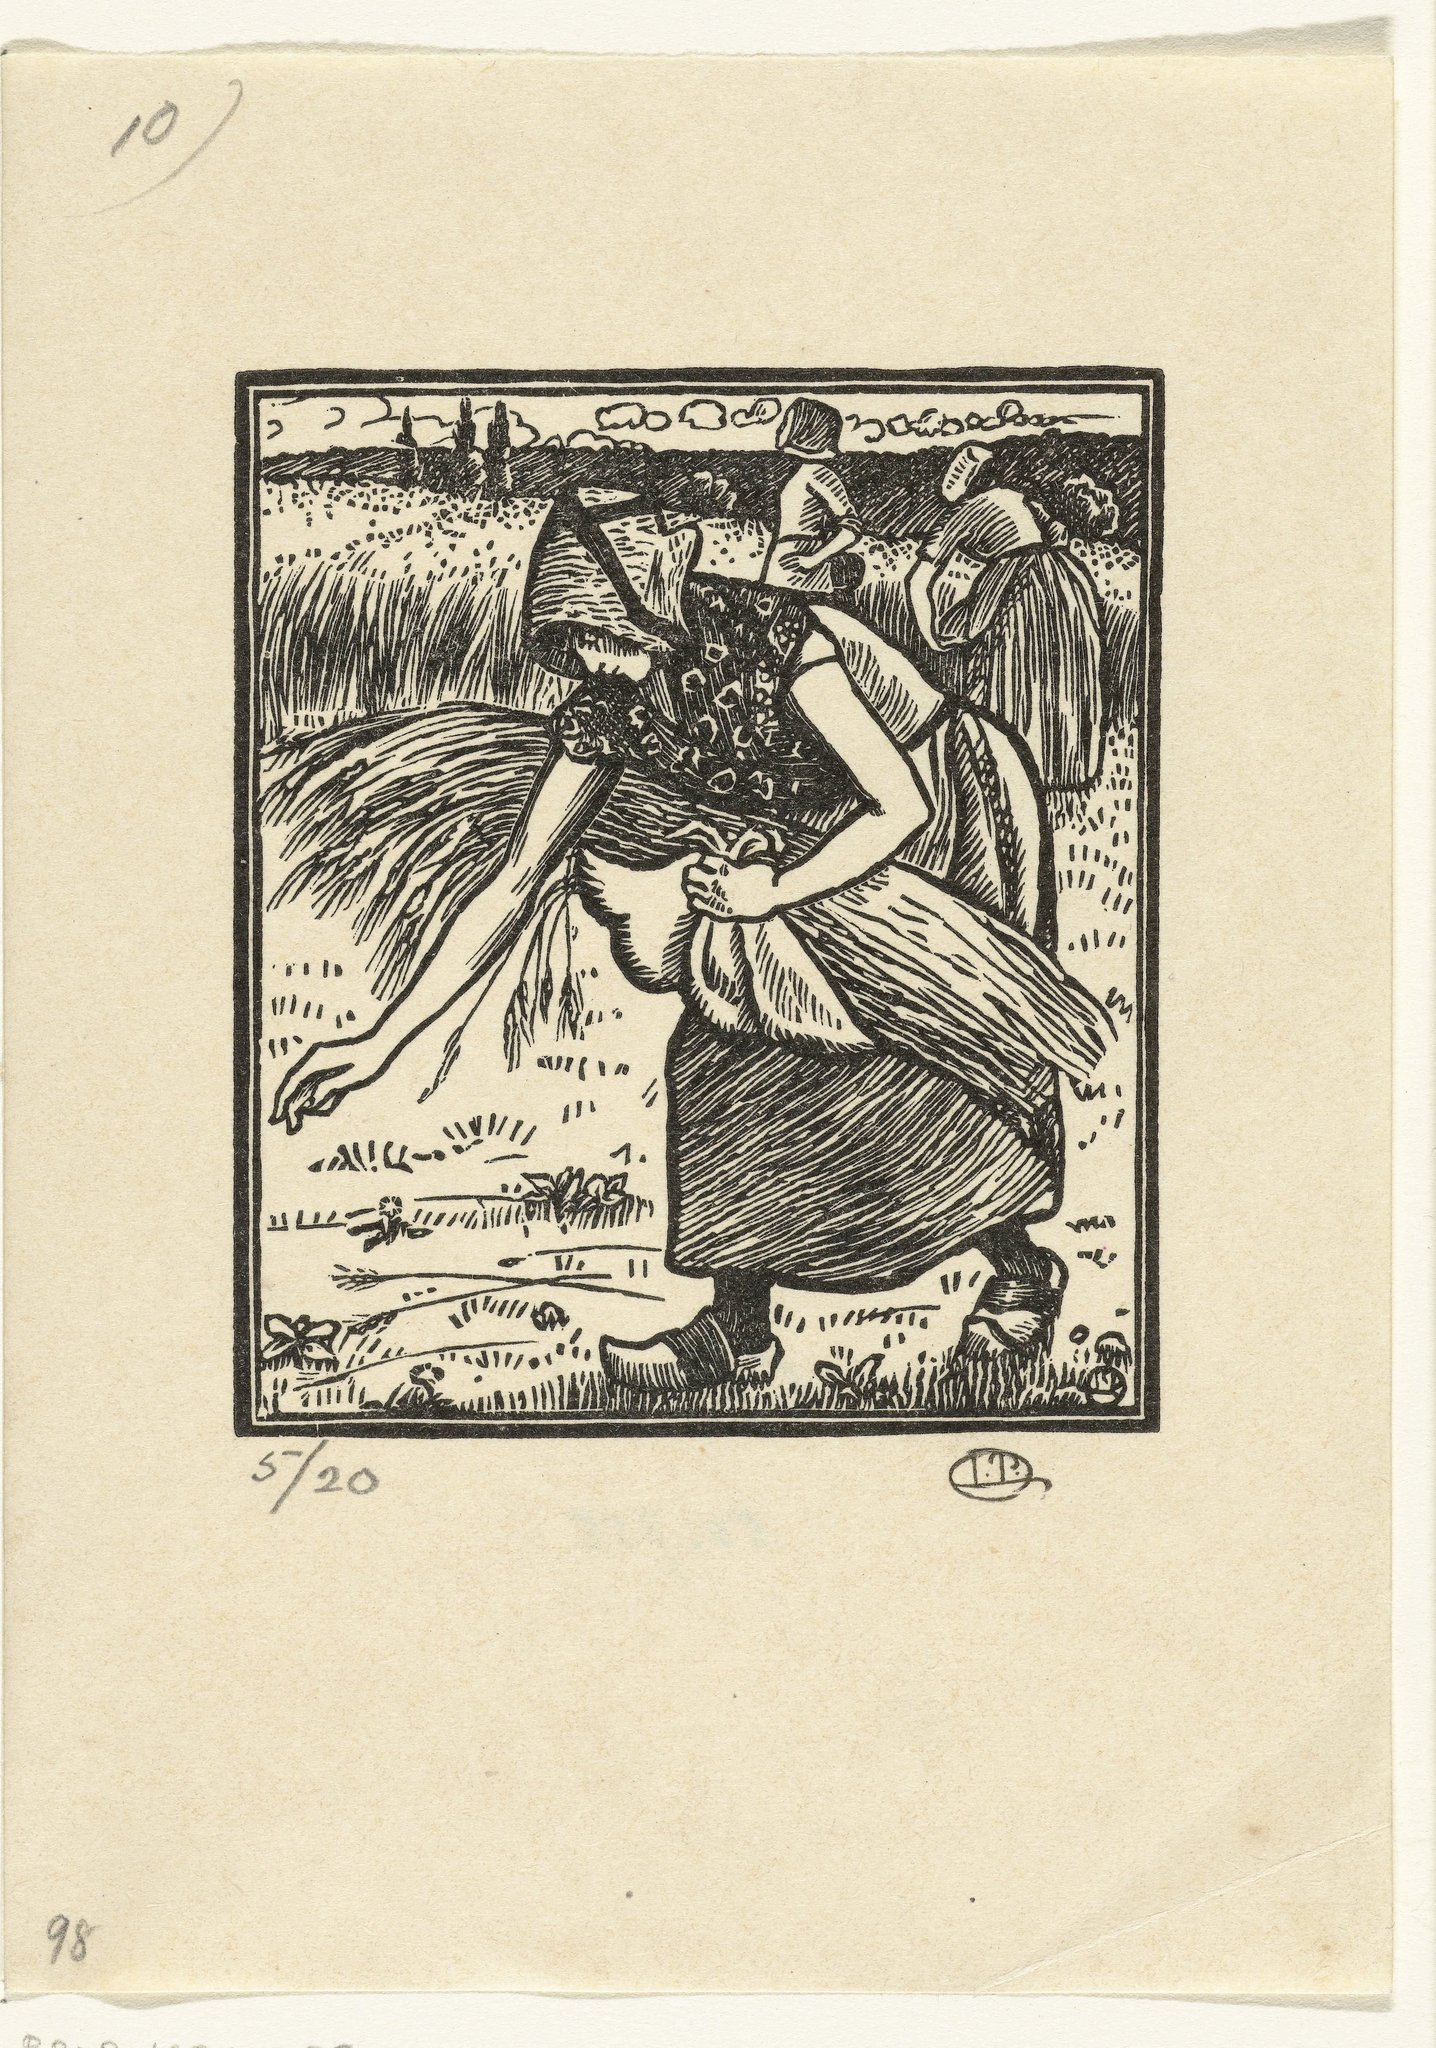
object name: print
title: Ruth verzamelt aren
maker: lucien pissarro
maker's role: painter, print maker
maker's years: 1863-1944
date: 1896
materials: paper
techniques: engraving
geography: hammersmith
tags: ruth gleaning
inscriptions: stamp: 1756b, collector's mark: Lugt 2228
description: De houtgravure is gemaakt als boekillustratie voor "The book of Ruth and the book of Esther", gedrukt bij Eragny (de drukkerij van Lucien Pissarro en zijn vrouw) in 1896 en verkocht bij Hacon en Ricketts. K.Botke